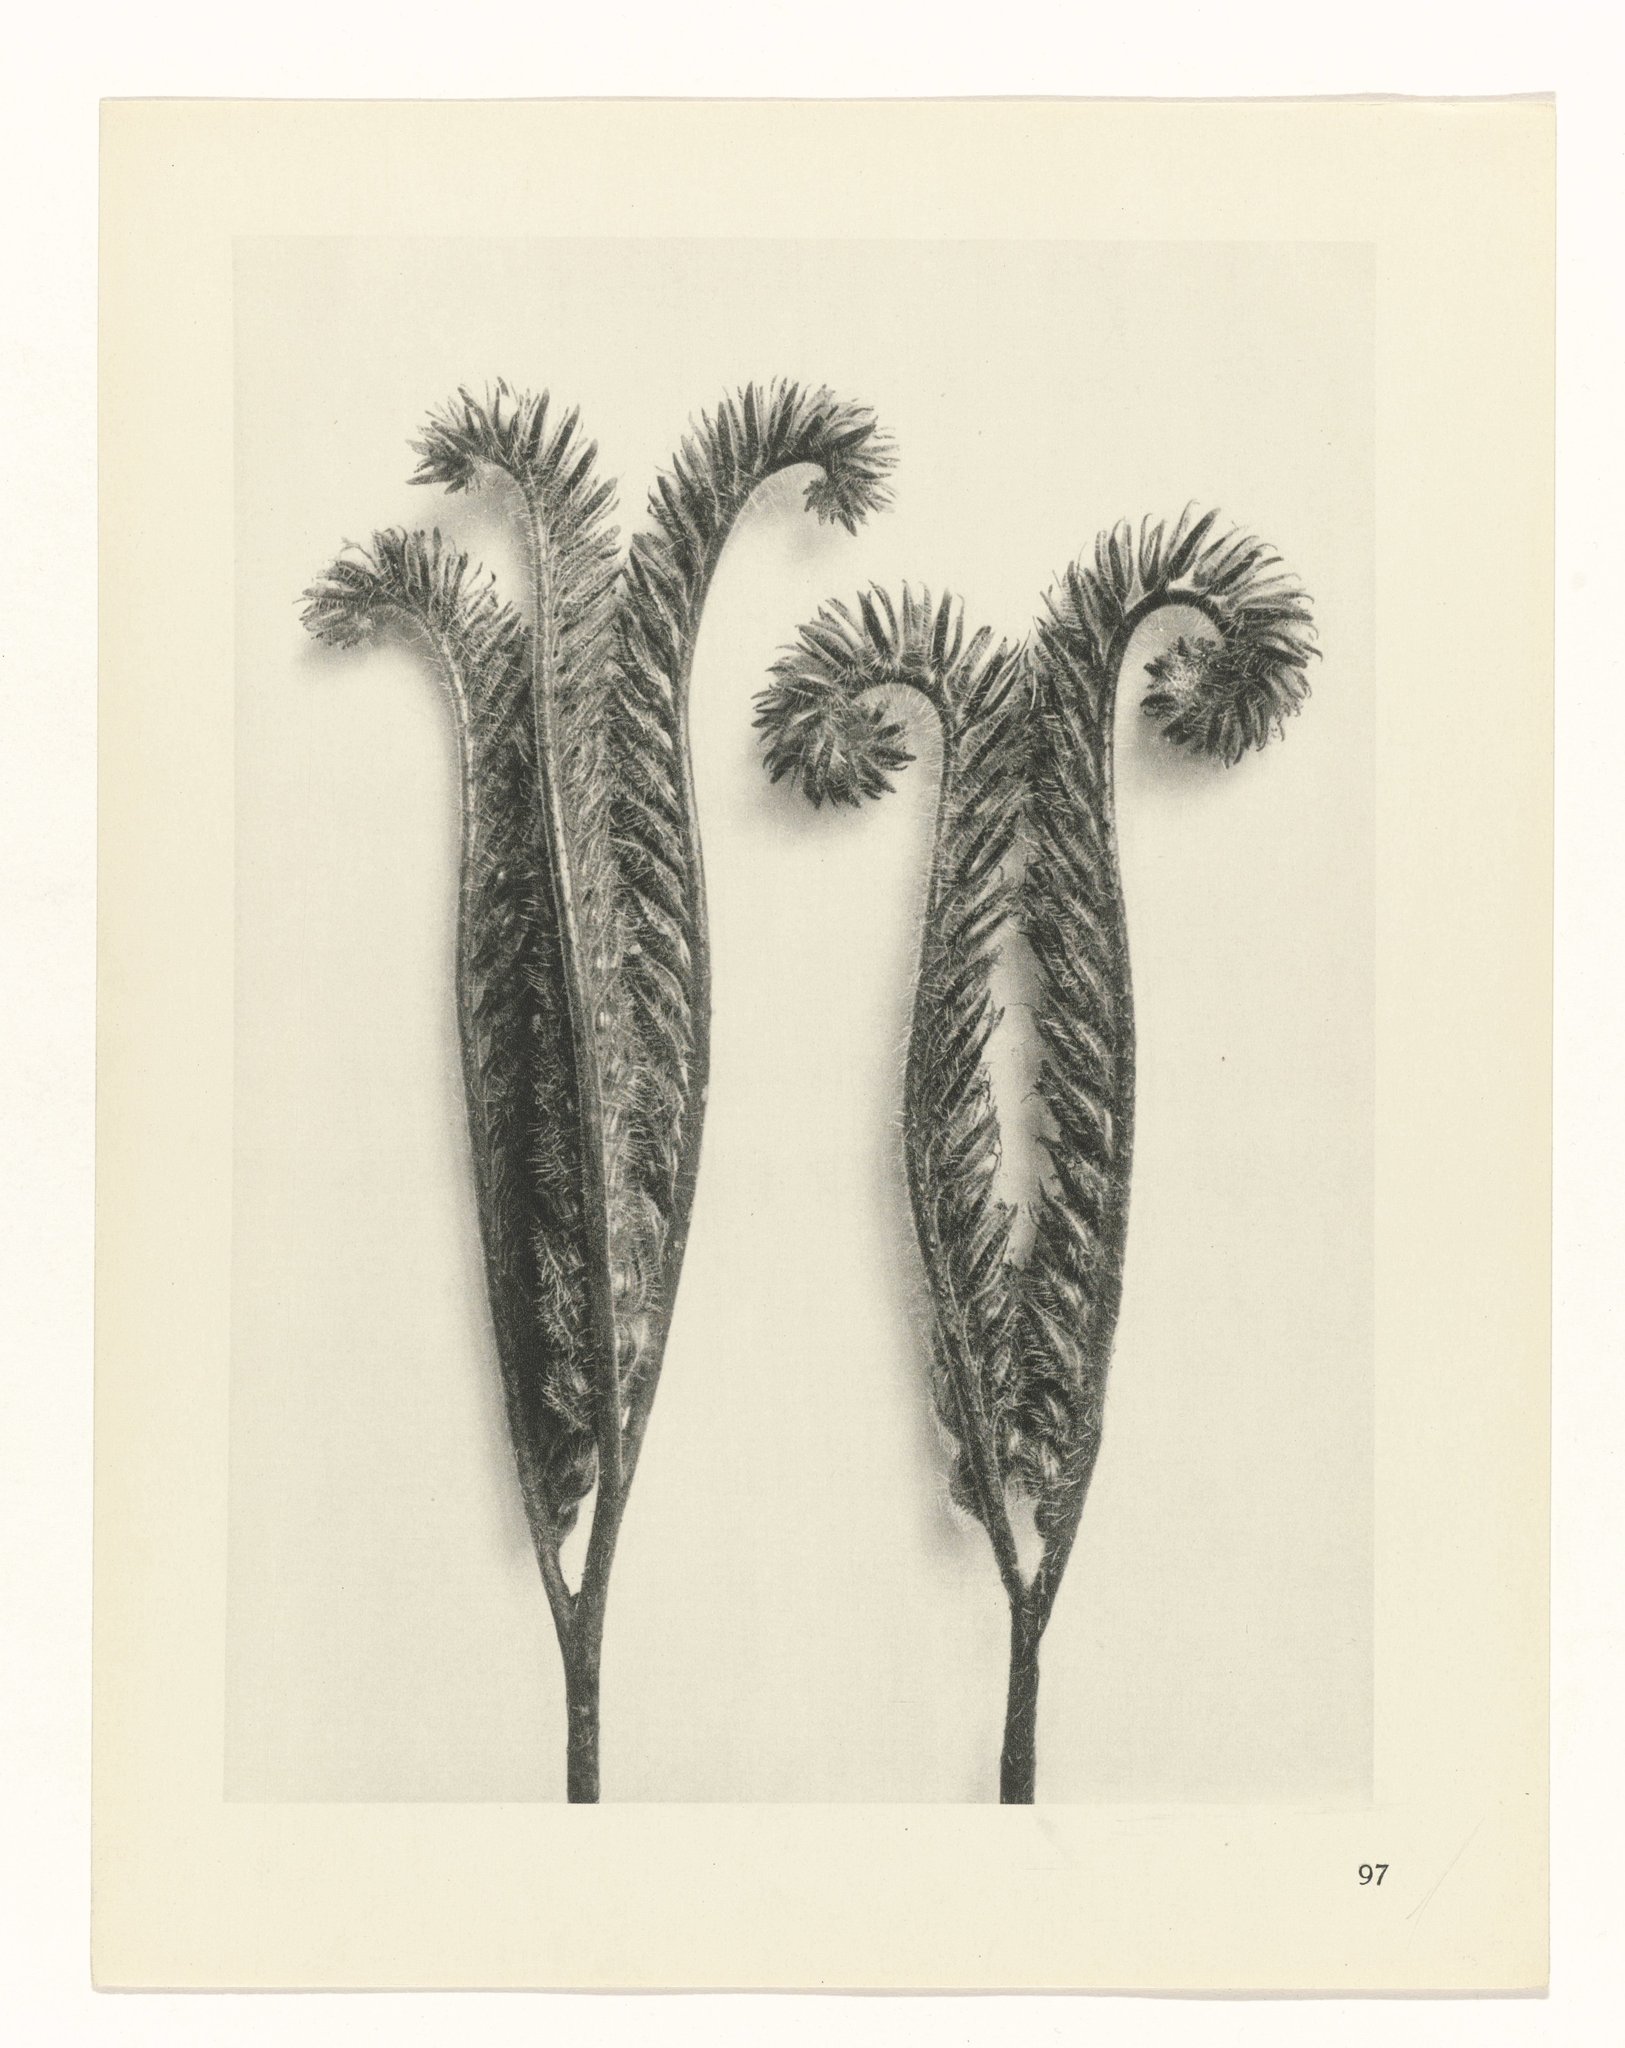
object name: photograph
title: Plantstudie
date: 1928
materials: ink, paper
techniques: rotogravure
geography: berlin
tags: plants (in general)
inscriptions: number: ‘97’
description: facher Vergrößerung. Afkomstig uit losbladige uitgave.